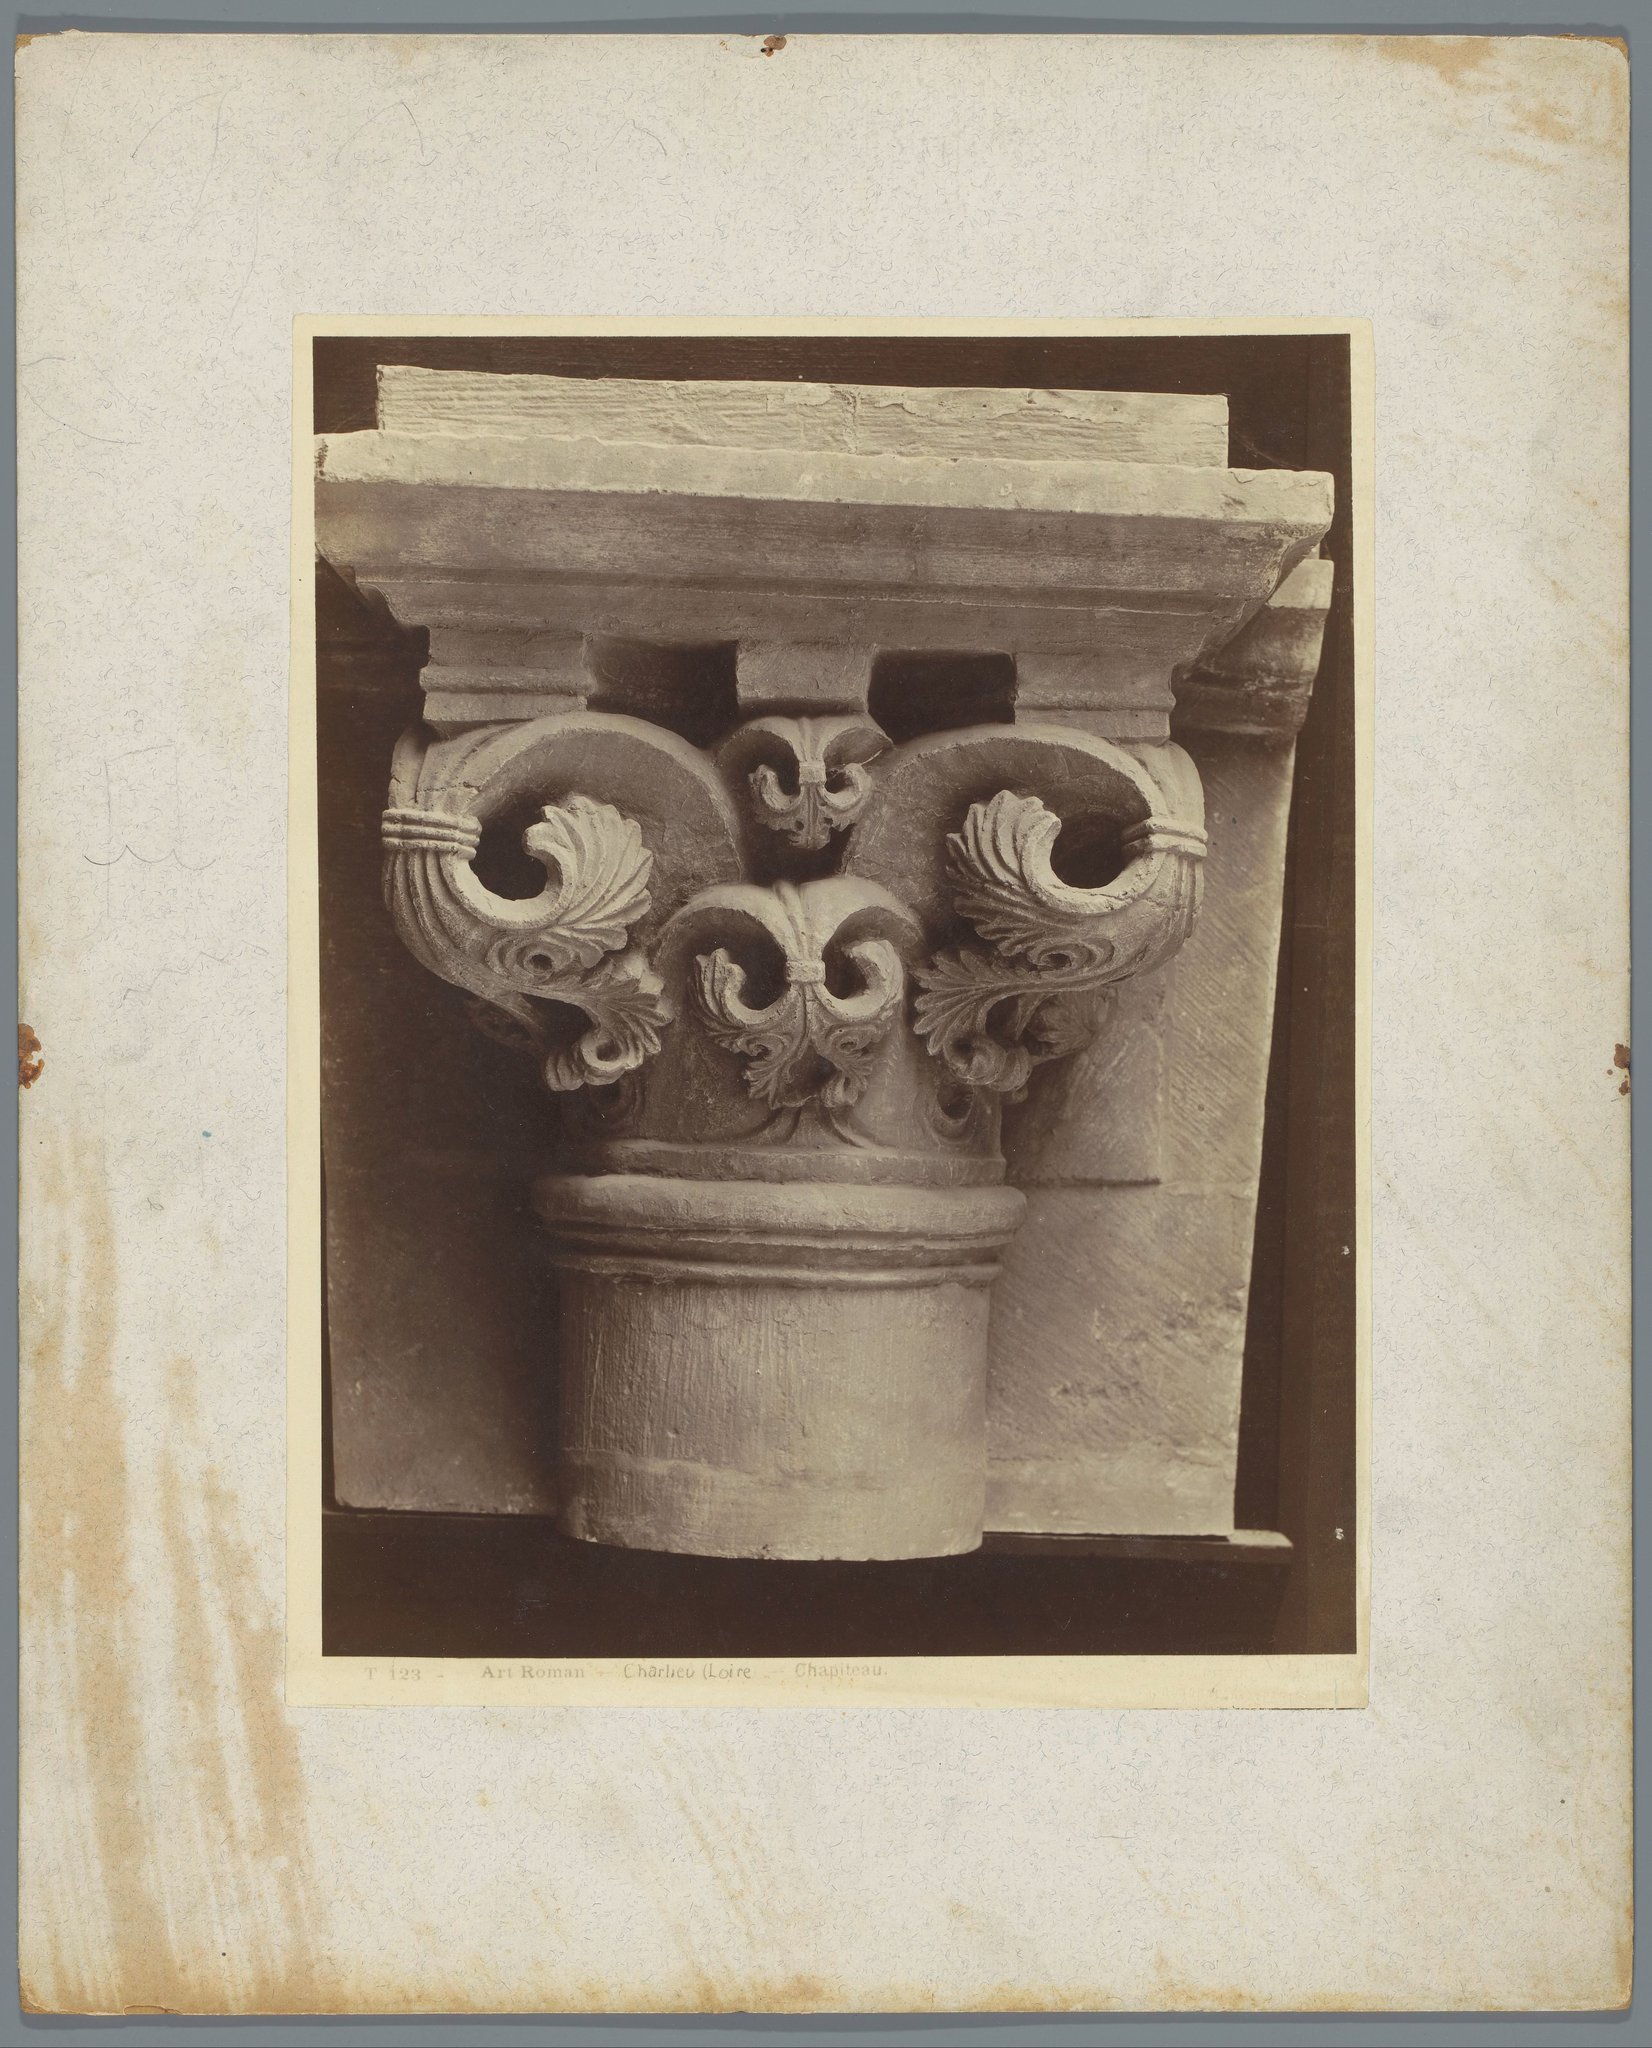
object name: photograph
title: Afgietsel van een kapiteel van de Abdij van Charlieu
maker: adolphe giraudon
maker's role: publisher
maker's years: 1849-1929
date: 1875-1900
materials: cardboard, photographic support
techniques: albumen print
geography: paris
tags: acanthus ~ ornament, capital (~ column, pillar)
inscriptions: number: ‘T 123’, name: ‘A. GIRAUDON ÉDITEUR 15, R. BONAPARTE, PARIS’